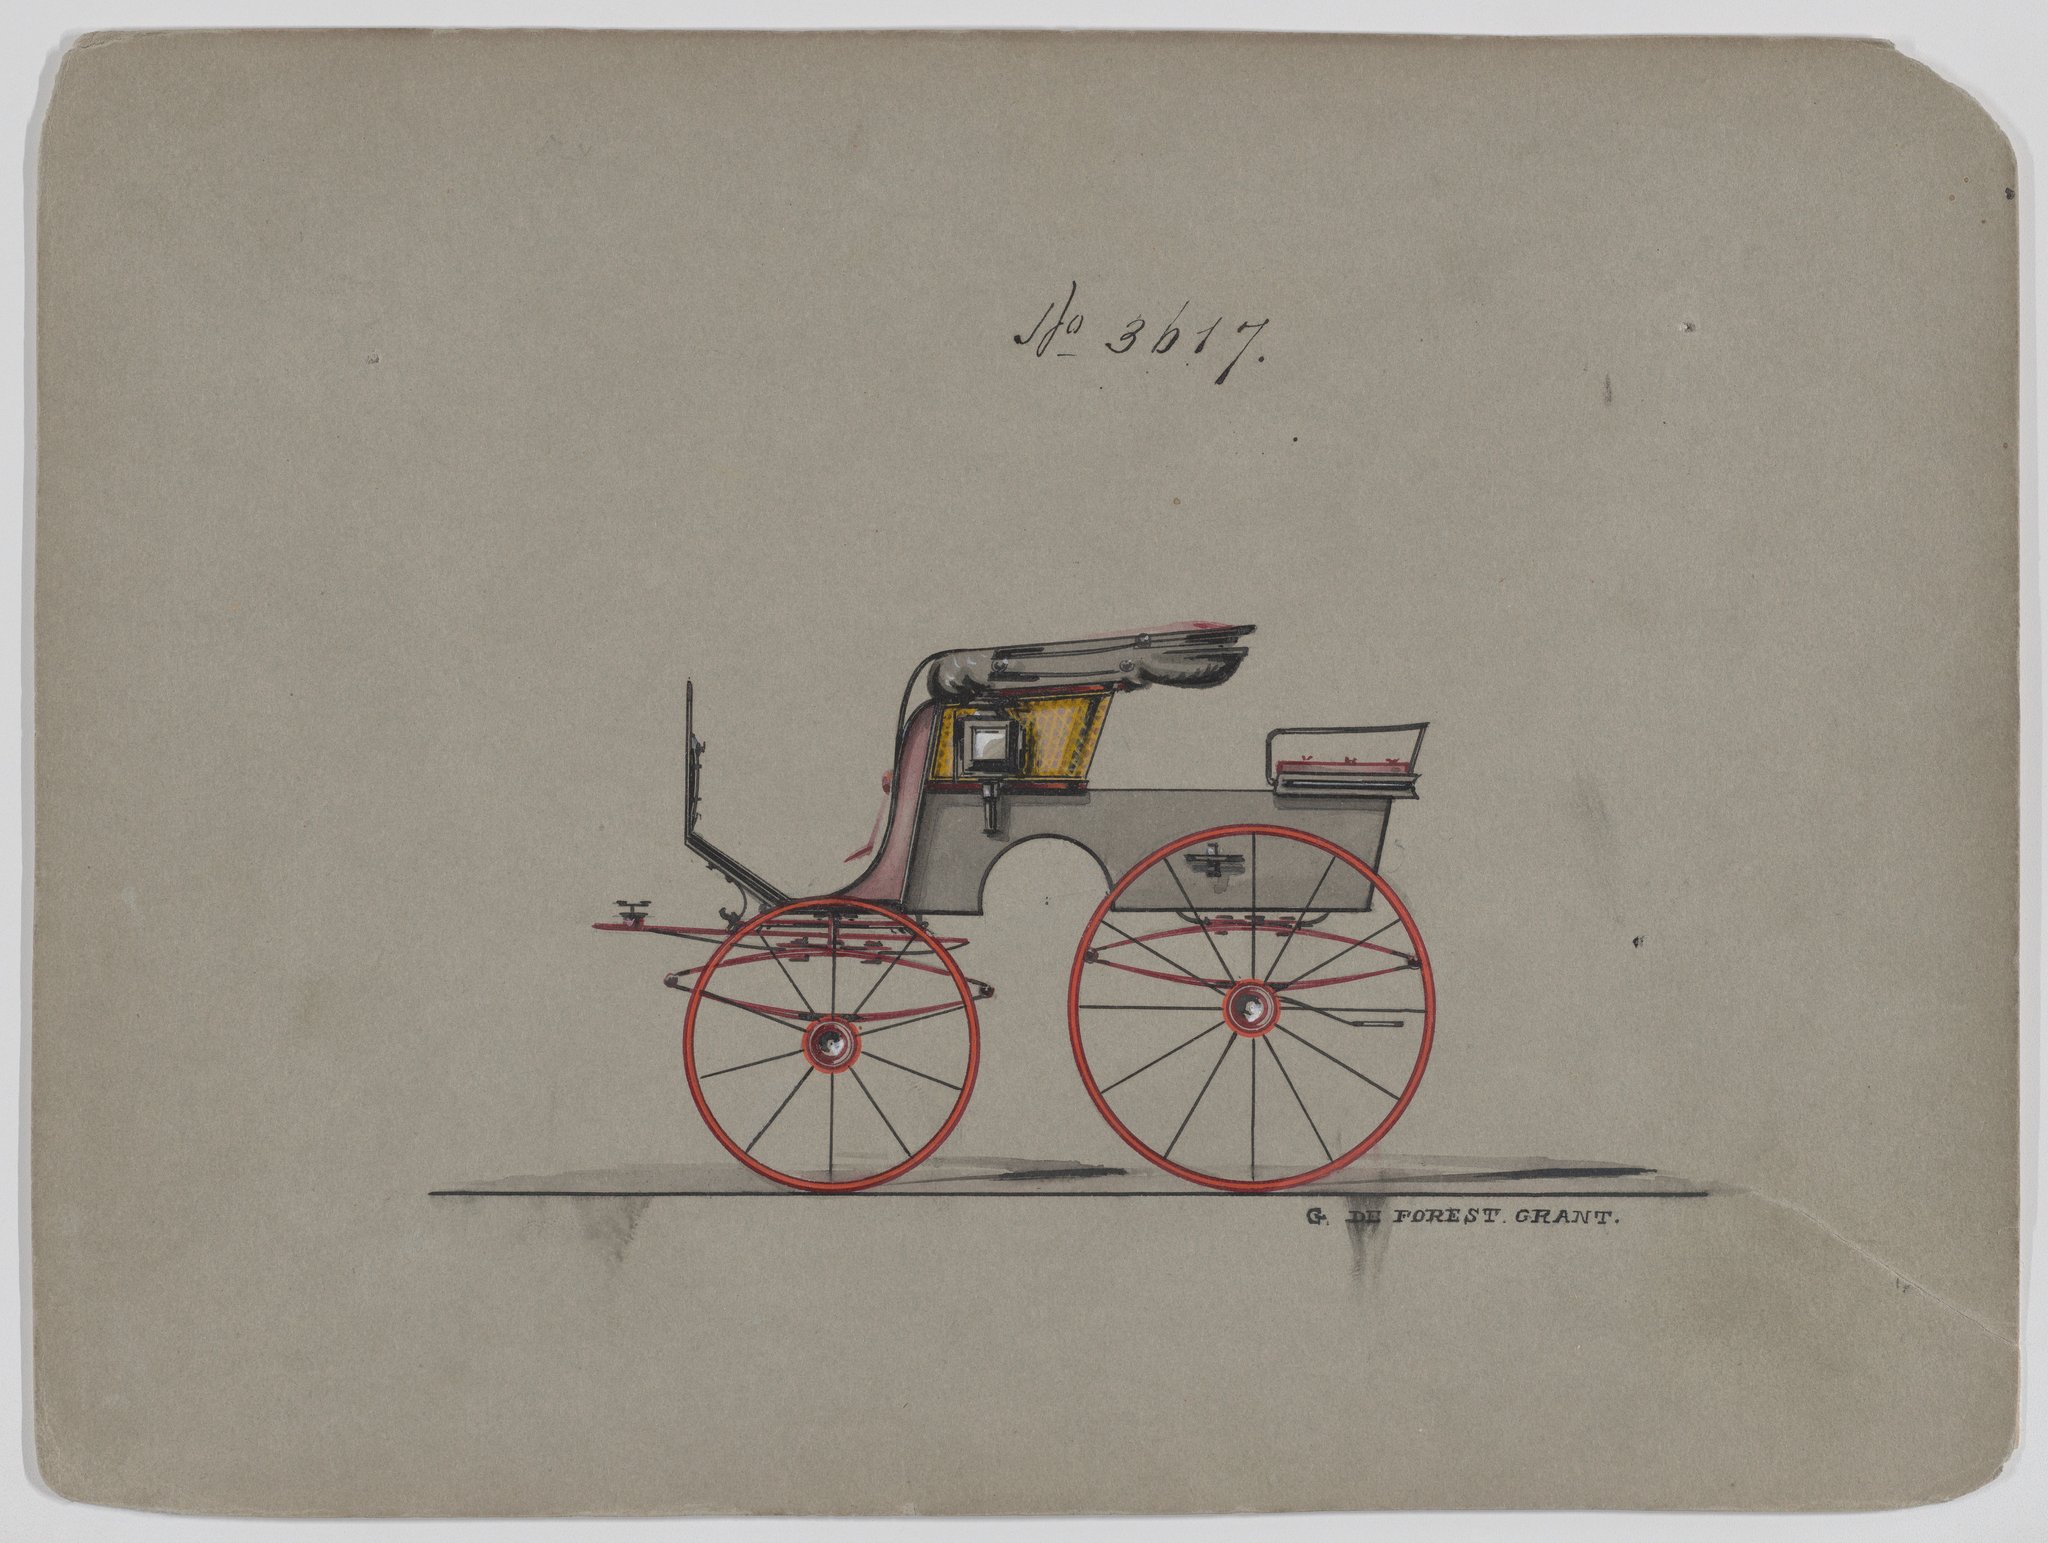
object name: drawing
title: Design for 4 Seat Phaeton, no. 3617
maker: brewster & co.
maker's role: manufacturer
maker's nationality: american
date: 1880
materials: gouache, gum arabic, ink, watercolor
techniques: pen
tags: carriages